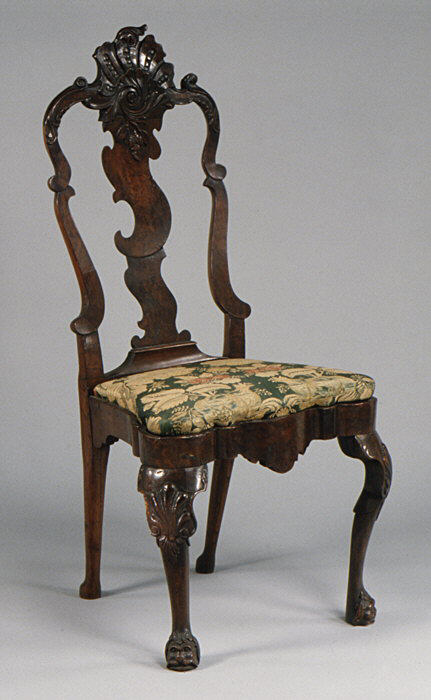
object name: side chair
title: Pair of side chairs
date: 1725-1750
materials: wood